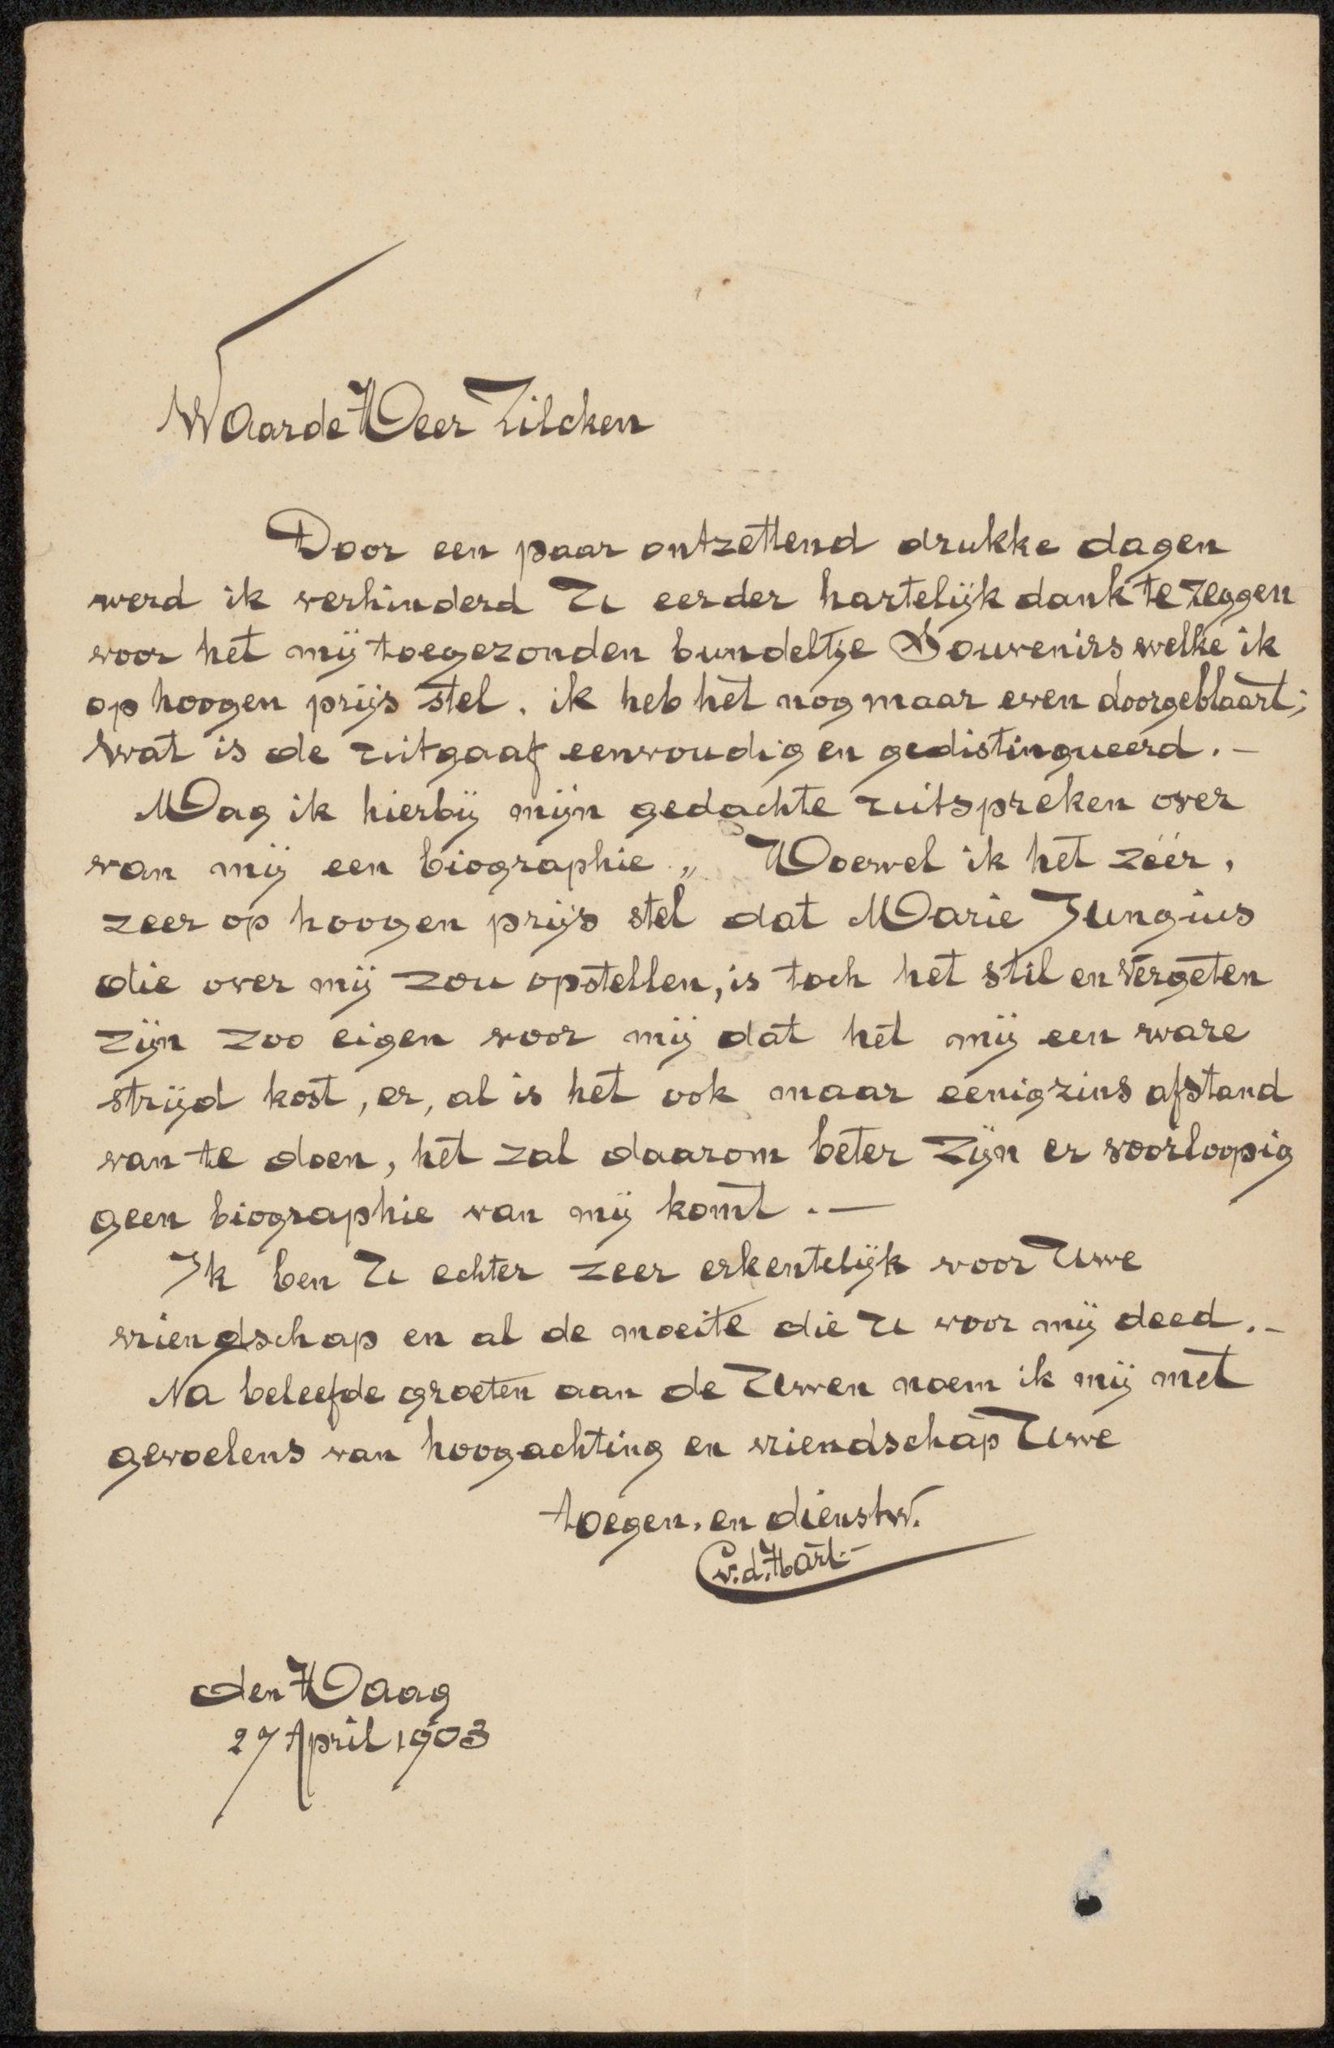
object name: letter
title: Brief aan Philip Zilcken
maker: cornelia van der hart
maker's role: print maker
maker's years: 1851-1940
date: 1903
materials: ink, paper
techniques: pen, writing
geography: the hague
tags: arnhem, hendrika maria aleida jungius, painter, draughtsman, philip zilcken, literature ~ arts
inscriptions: collector's mark: ‘RPK’